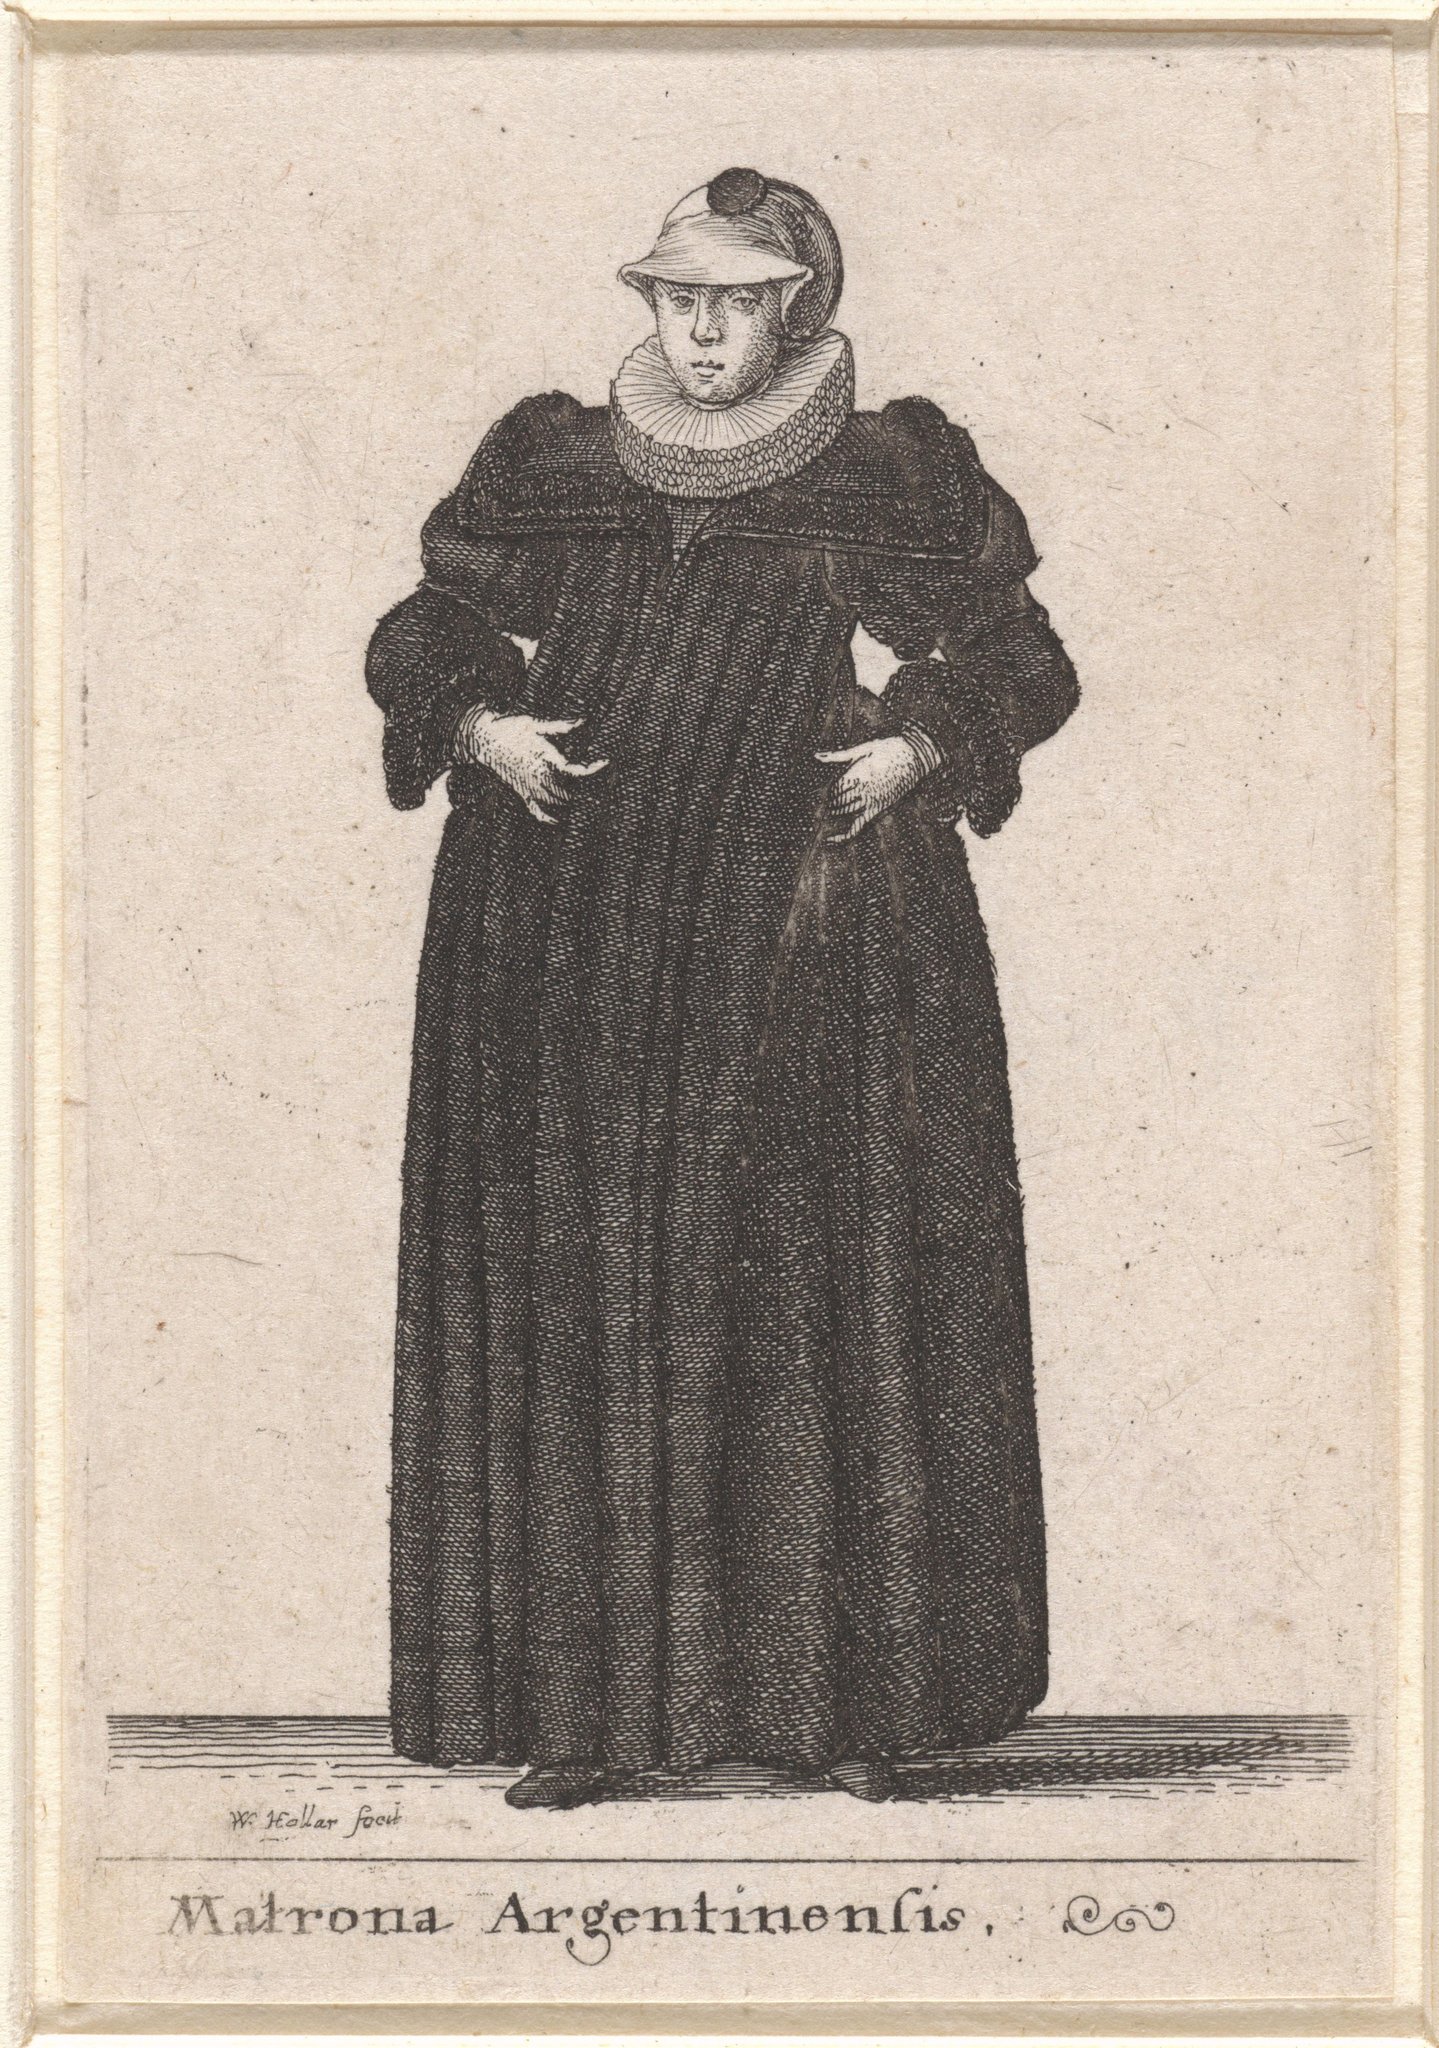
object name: costume print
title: Vrouw uit Straatsburg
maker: wenceslaus hollar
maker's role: draughtsman, print maker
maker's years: 1607-1677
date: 1644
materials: paper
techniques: etching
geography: london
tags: coat (+ fur used for clothes), coat (+ women's clothes), head-gear: cap (+ women's clothes), clothes, costume (+ women's clothes), neck-gear ~ clothing (with name) (+ women's clothes), sleeves (+ women's clothes), europeans: germans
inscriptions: collector's mark: Lugt 240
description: Vrouw uit Straatsburg, van voren gezien, in een geplooid overkleed met platte kraag en poffende, halflange mouwen. Muts met vooruitstekende klep. Lijf met nauwsluitende mouwen met manchetten. Smalle plooikraag.